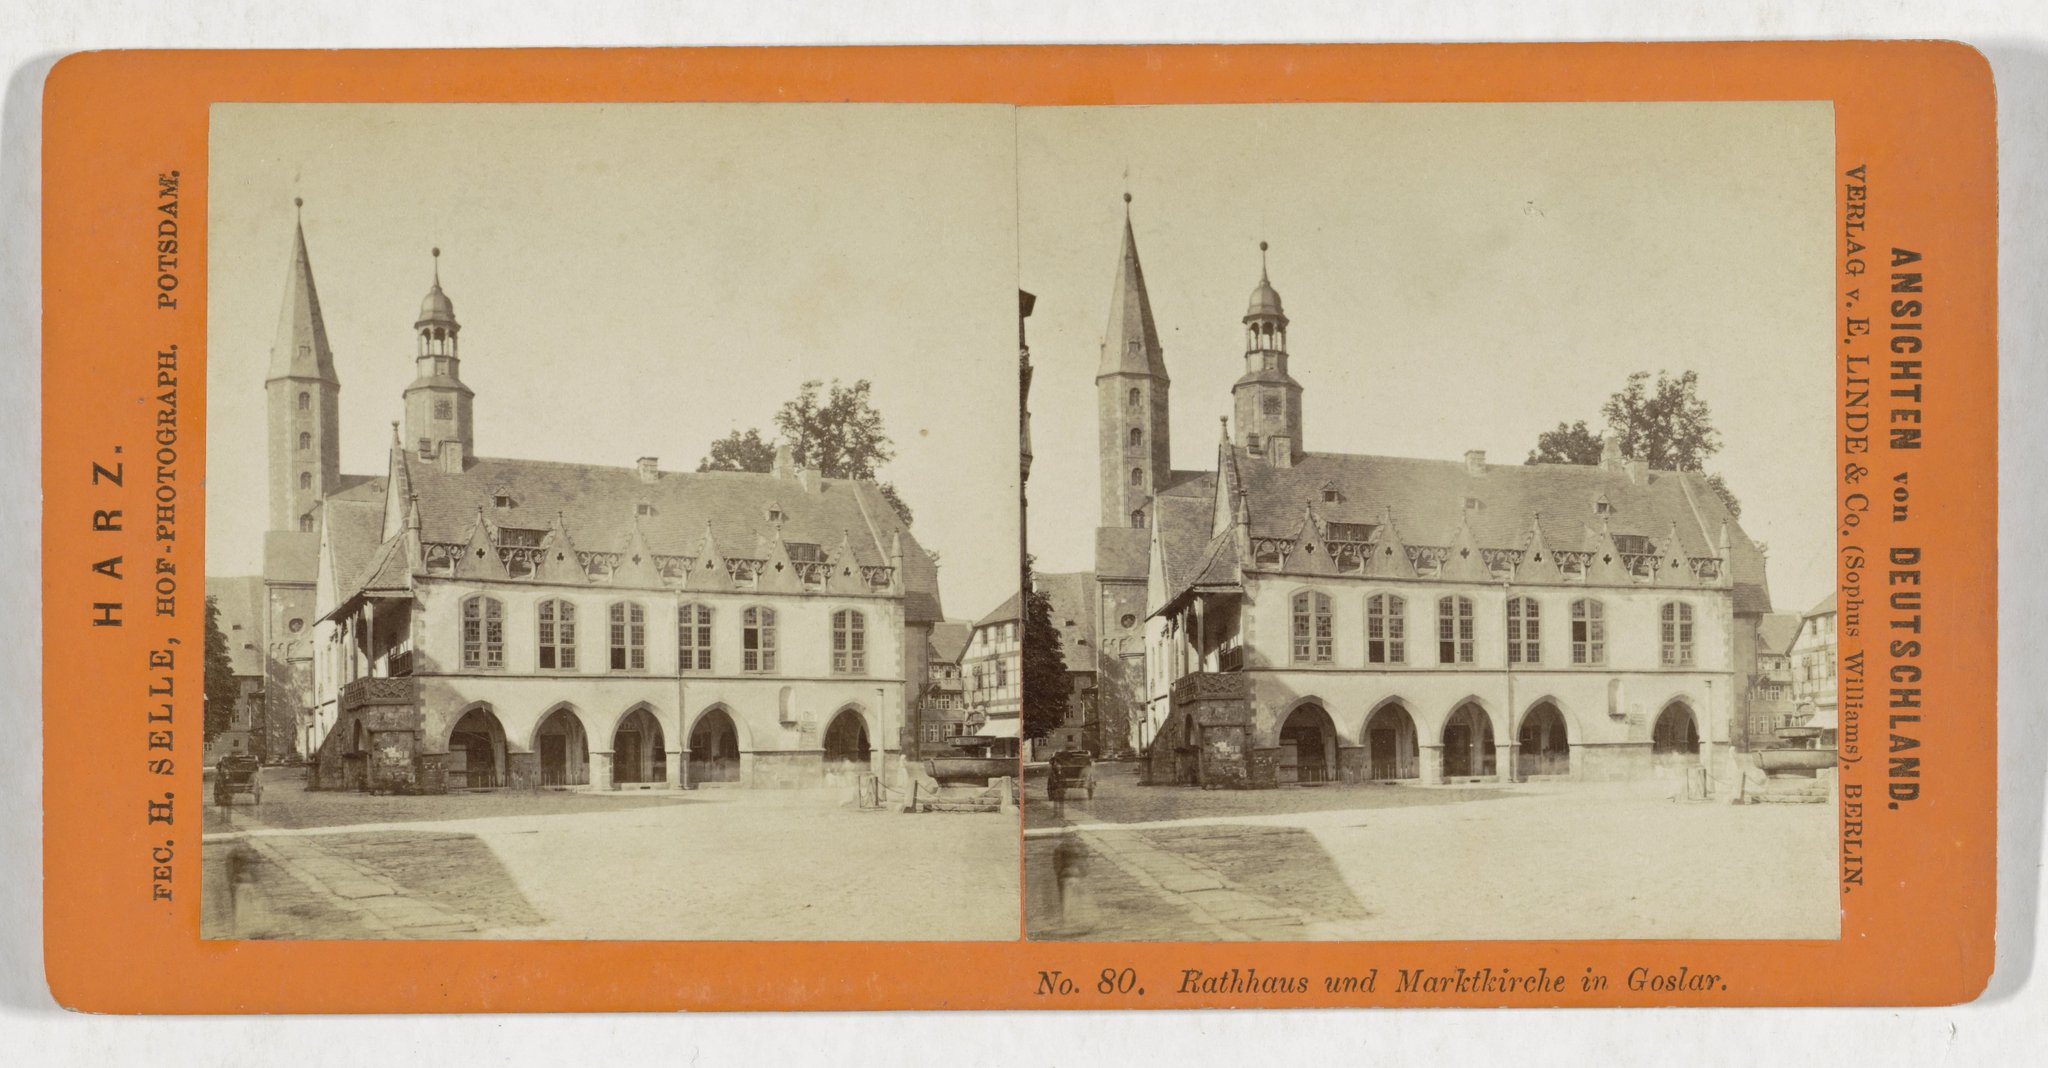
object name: stereograph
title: Stadhuis en Marktkerk van Goslar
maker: hermann selle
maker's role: fotograaf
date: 1868-1890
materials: cardboard, paper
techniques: albumen print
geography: berlin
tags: townhall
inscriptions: inscription: ‘Hof-Photograph. Potsdam.’, number: ‘No. 80.’